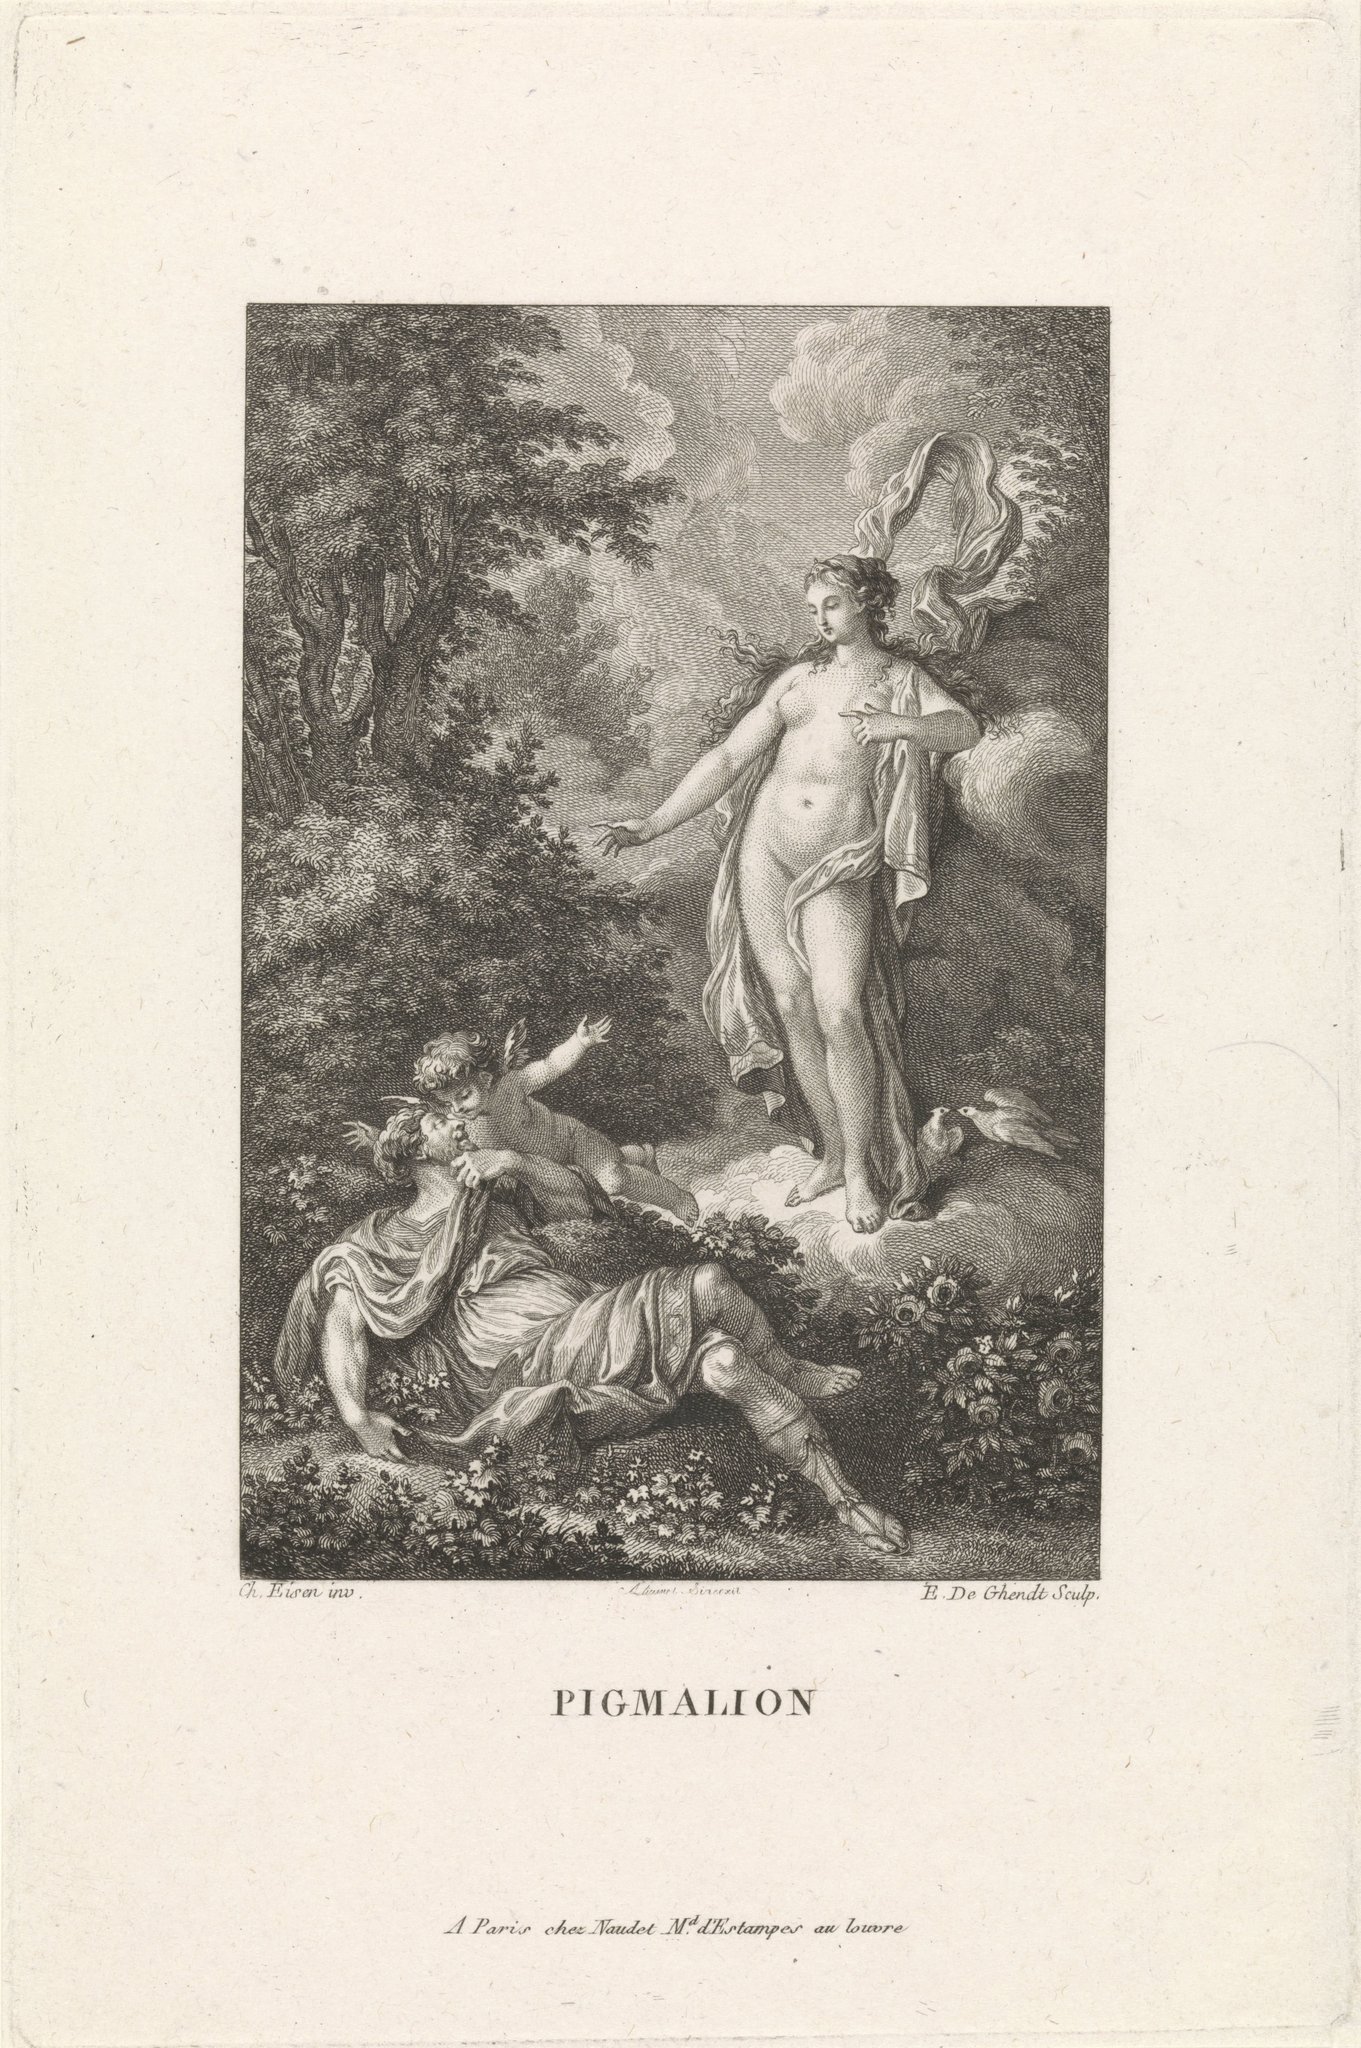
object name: print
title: Pygmalion wordt in een droom door Venus bezocht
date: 1748-1815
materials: paper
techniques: engraving, etching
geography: paris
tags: venus and cupid (cupid not being mere attribute), pygmalion prays to venus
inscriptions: collector's mark: Lugt 2228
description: Venus verschijnt aan Pygmalion in een droom. Cupido maakt de beeldhouwer wakker. De prent maakt deel uit van een serie over het verhaal van Pygmalion.